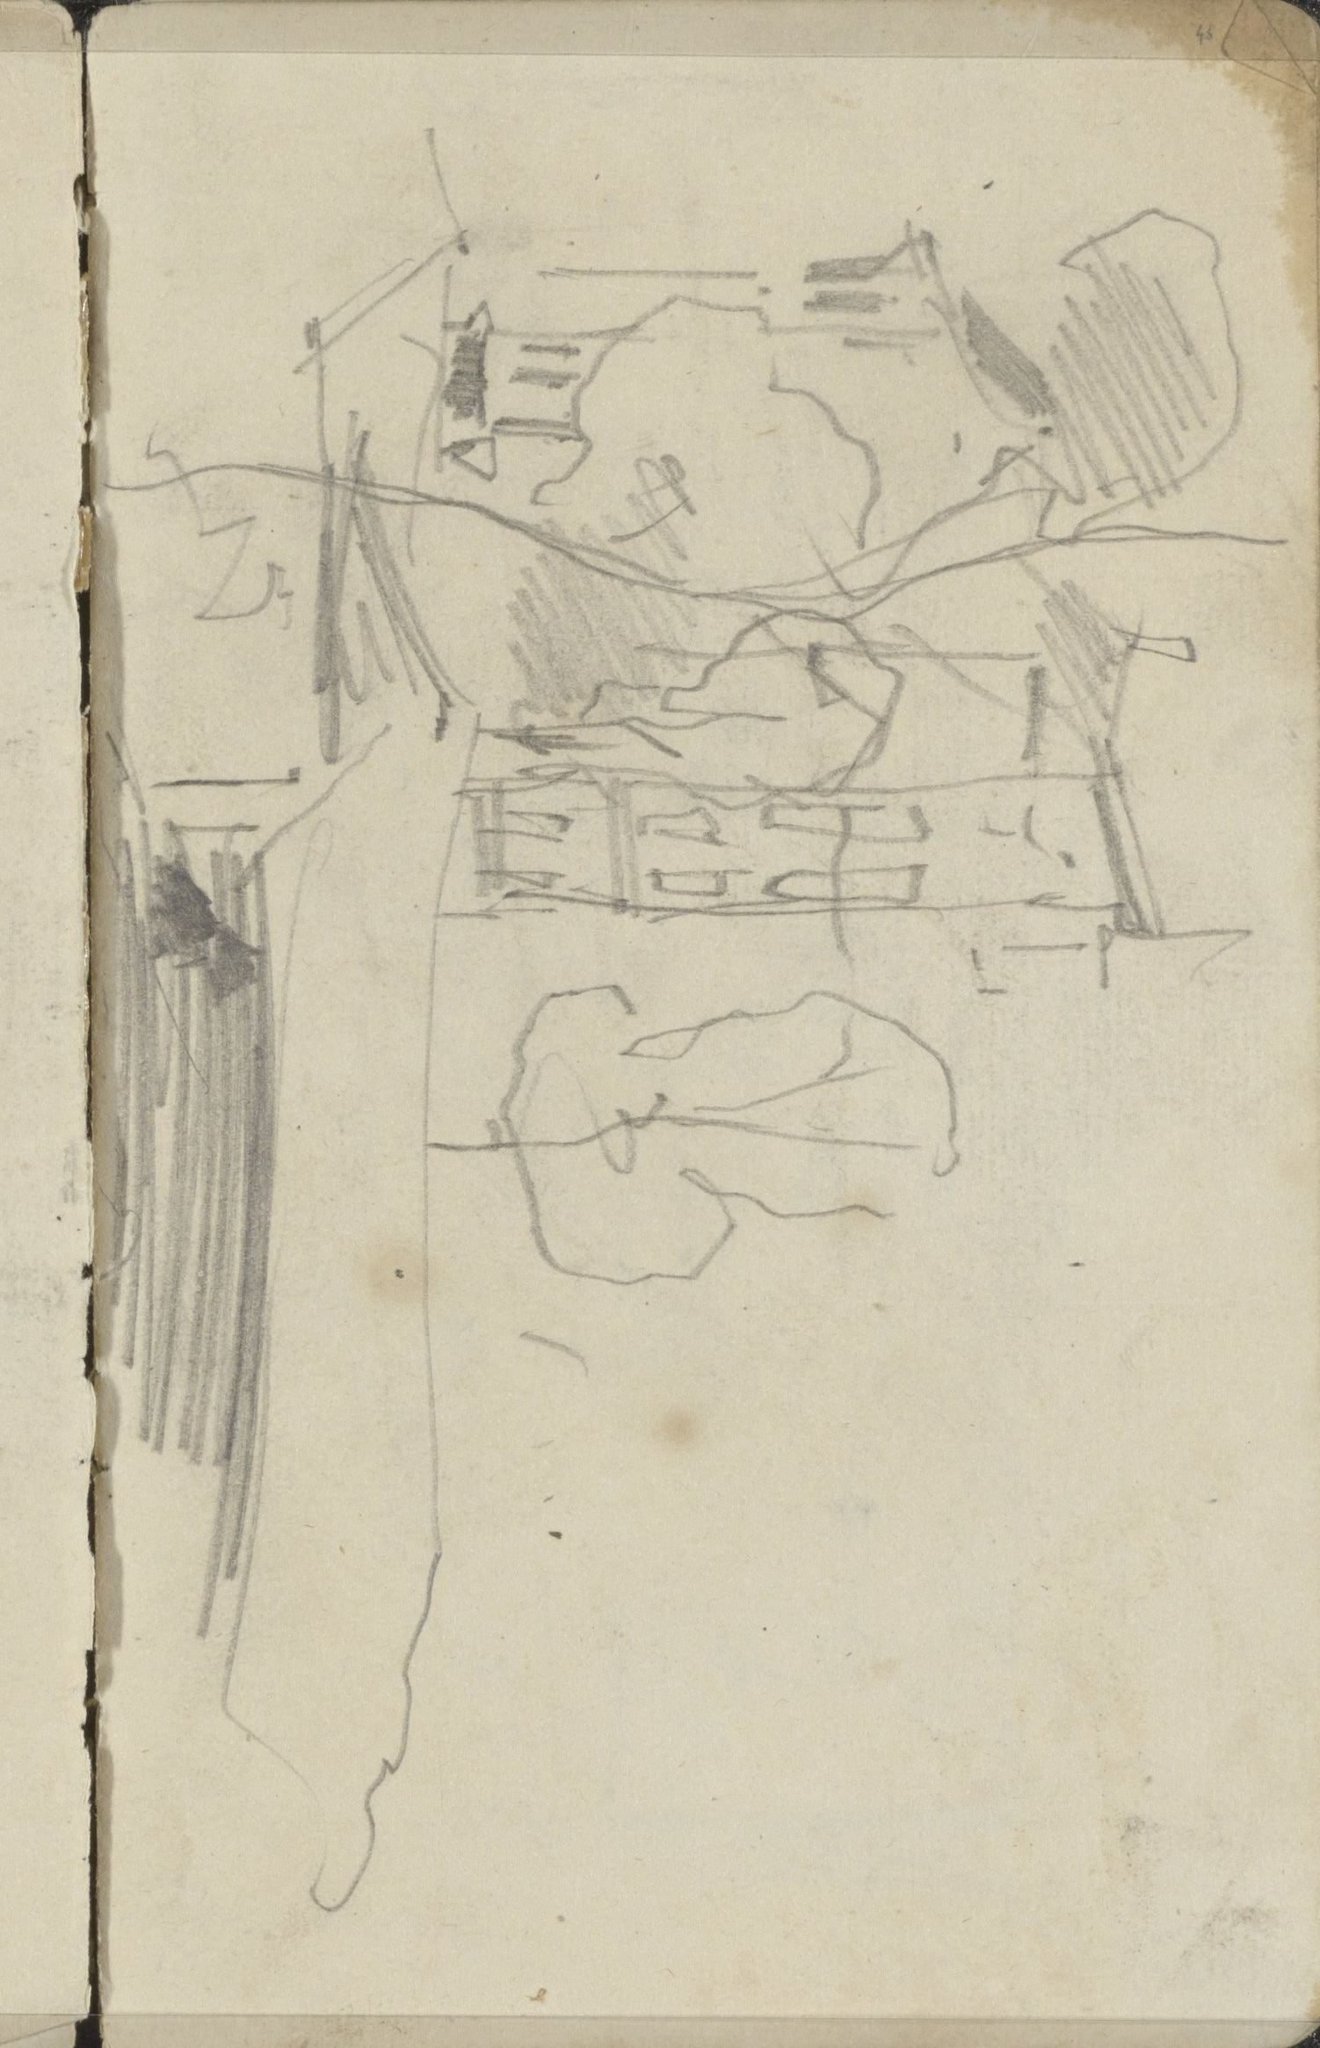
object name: sketchbook leaf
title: Stadsgezicht met marktkramen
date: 1881-1883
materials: paper, pencil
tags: urban housing, city-view, and landscape with man-made constructions, stall, booth (~ market)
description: Pagina 45 uit een schetsboek met 29 bladen.